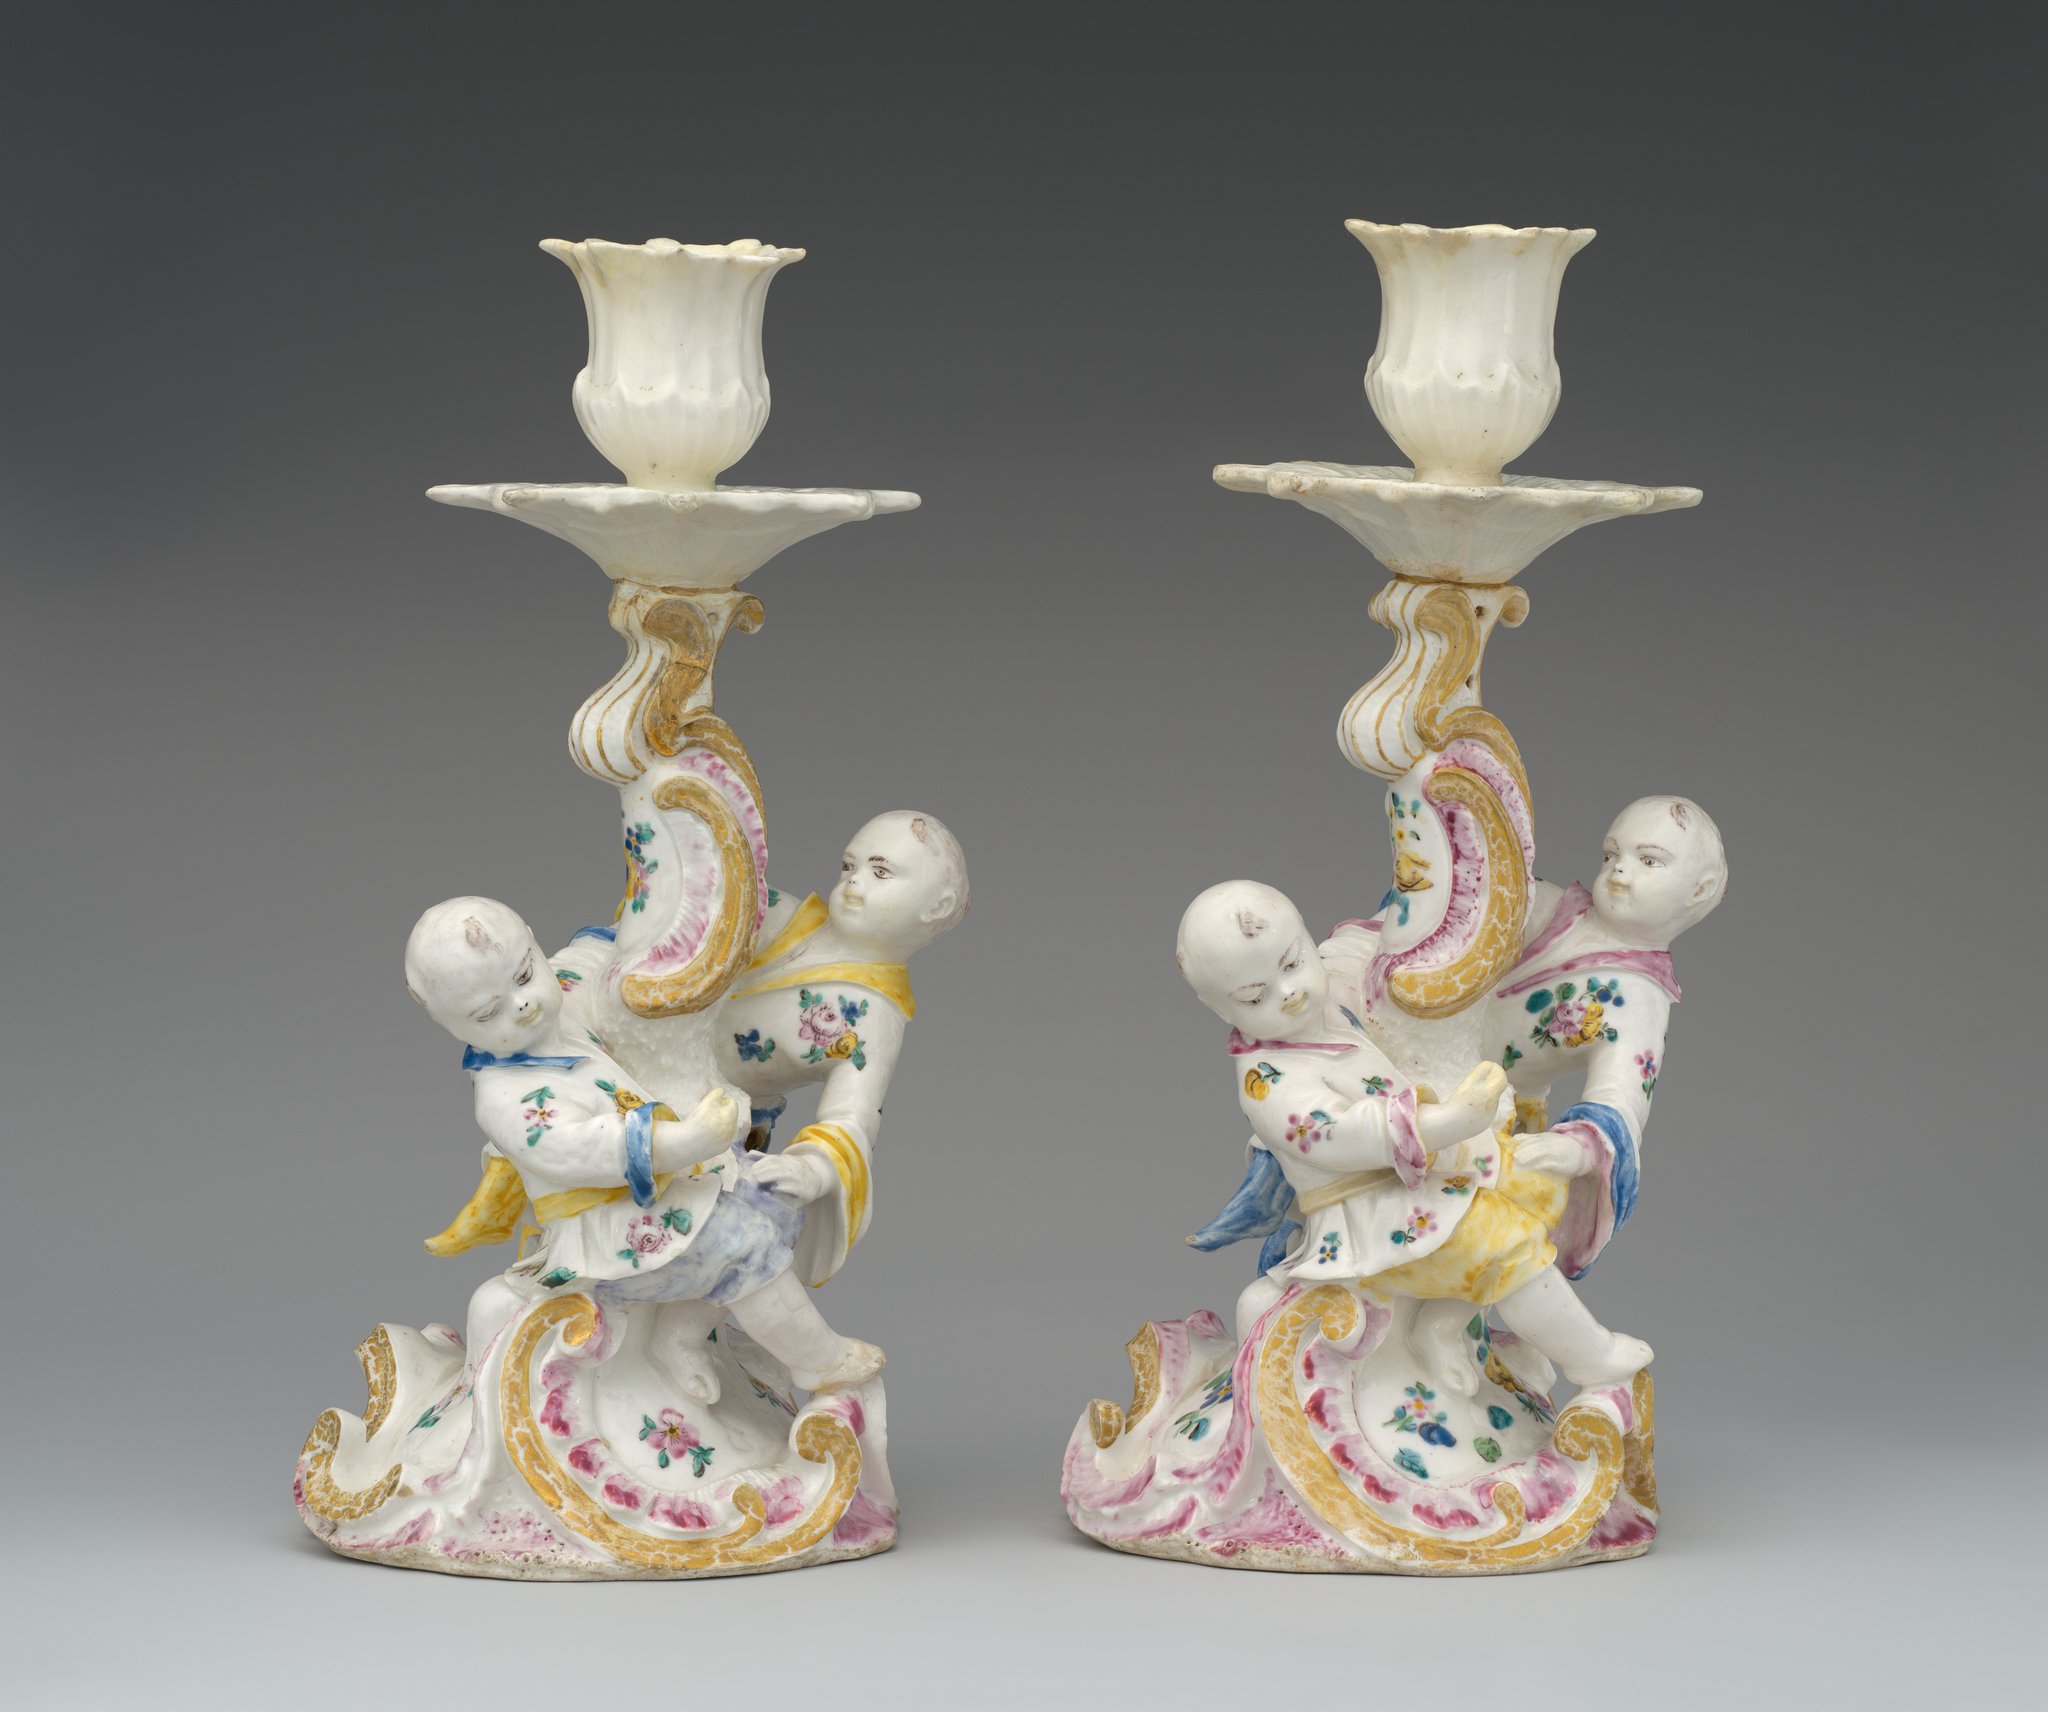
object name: candlestick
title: Pair of candlesticks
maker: derby porcelain manufactory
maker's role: factory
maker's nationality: british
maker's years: 1751-1785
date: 1756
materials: soft paste porcelain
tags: boys